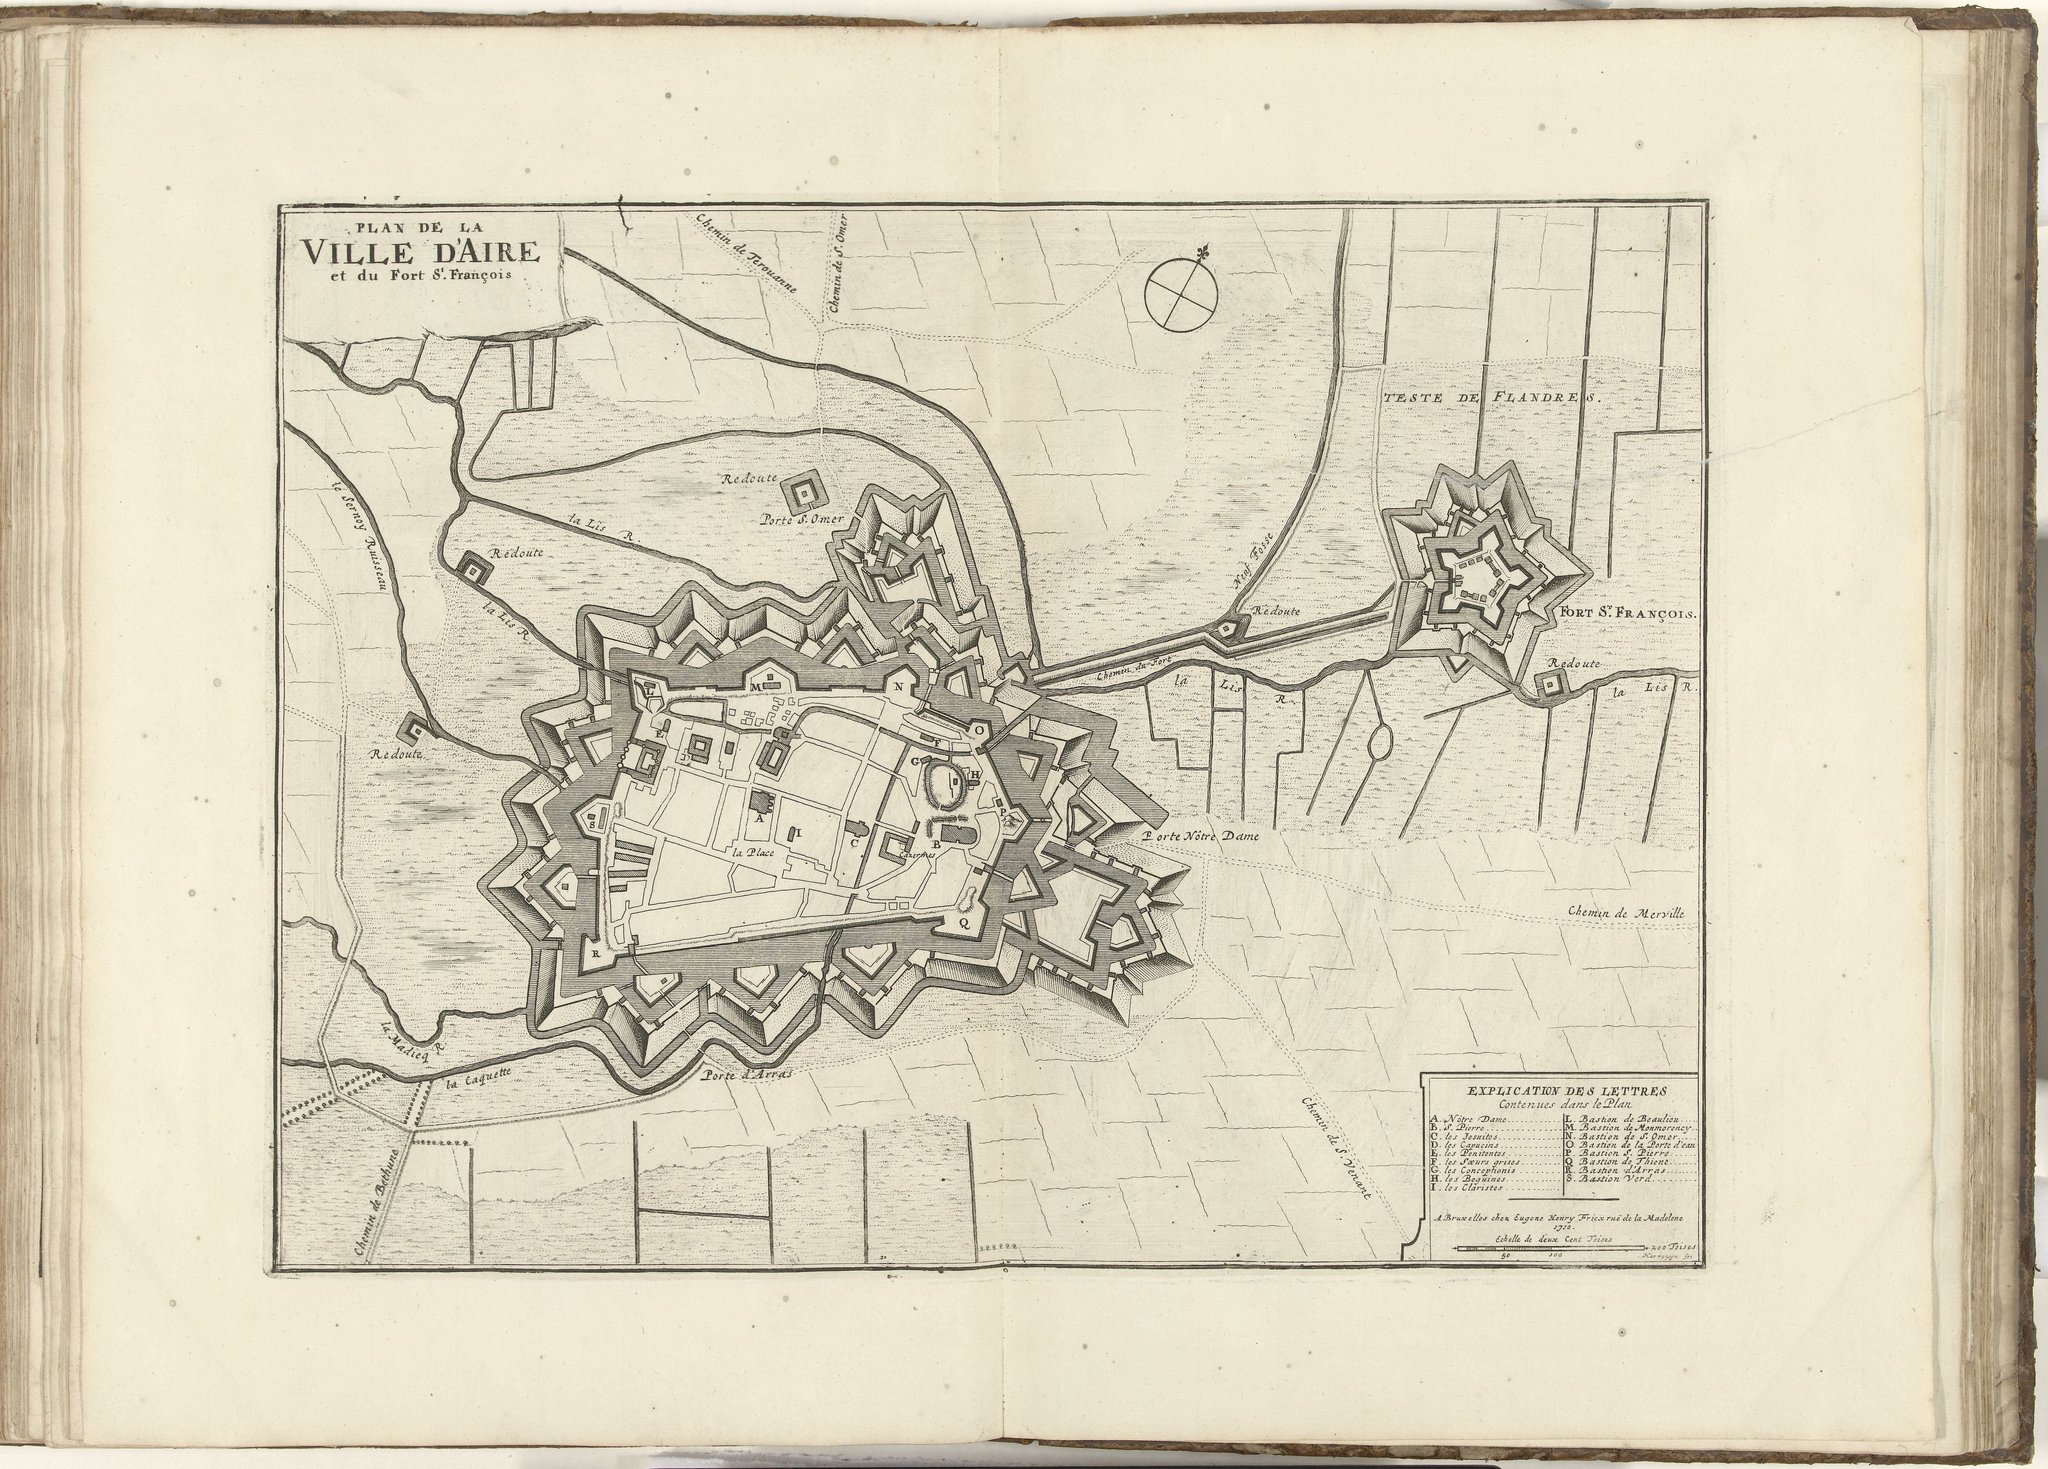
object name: map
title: Plattegrond van Aire, 1710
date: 1710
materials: paper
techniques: etching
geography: brussels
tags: maps of cities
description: Plattegrond van de versterkingen om de stad Aire en het Fort St. François, belegerd en ingenomen door de Geallieerden in 1710. Rechtsonder een cartouche met de legenda A-S in het Frans. Onderdeel van een gebundelde verzameling van plannen van veldslagen en steden vermaard in de Spaanse Successieoorlog.